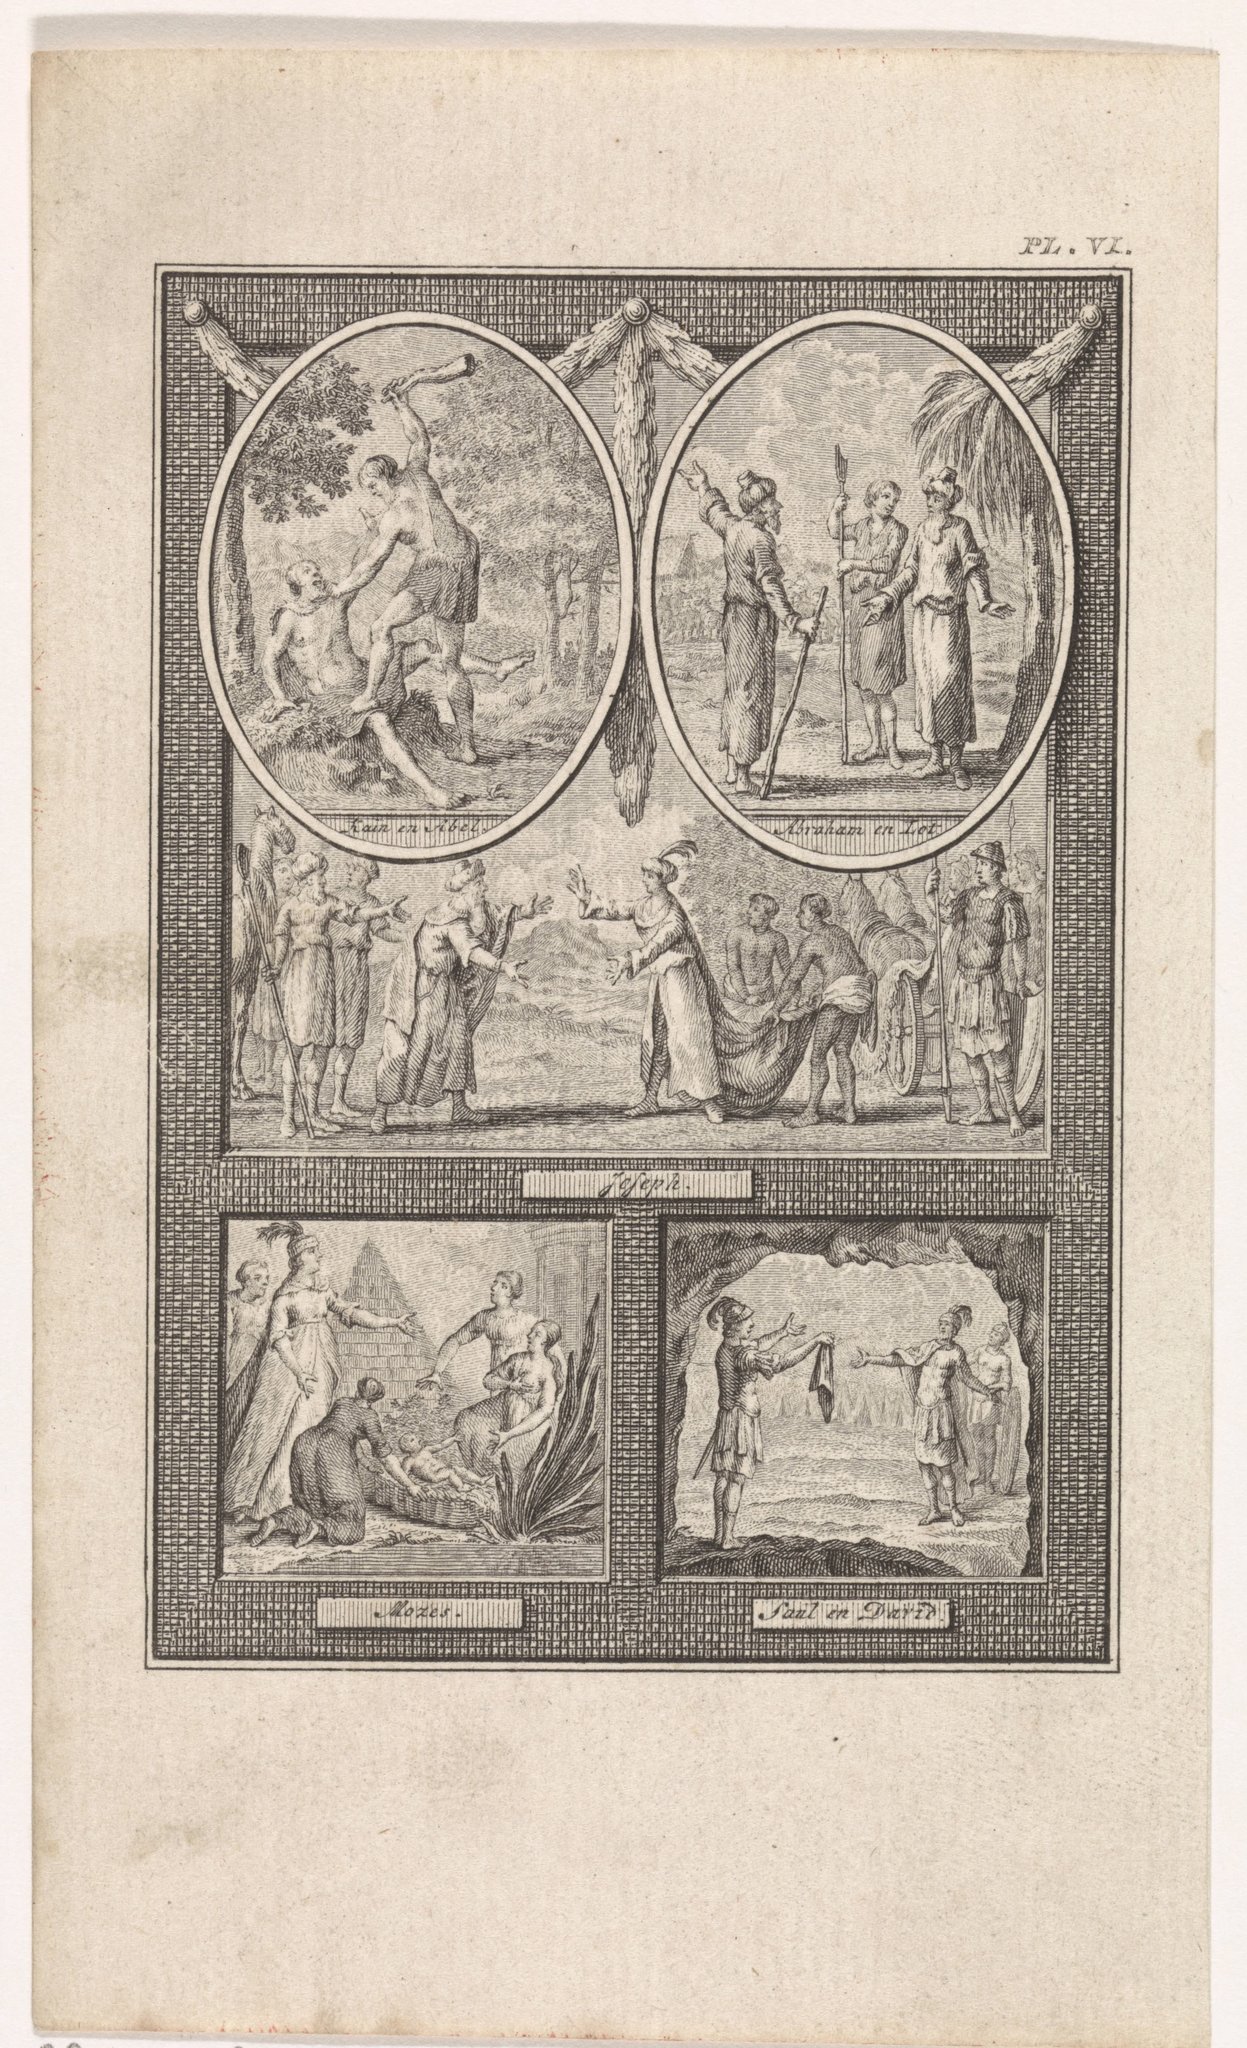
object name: book illustration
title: Vijf bijbelse taferelen op een blad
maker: theodoor koning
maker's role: print maker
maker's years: 1748-1829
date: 1794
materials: paper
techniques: etching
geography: amsterdam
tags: the killing of abel: cain slays him with a stone, a club or a jaw-bone, alternatively with a spade or another tool as weapon, saul and david in the same cave; saul relieving himself, abraham gives lot the choice of the surrounding country, joseph goes to goshen to meet his father, moses is either presented to pharaoh's daughter or surrounded by women fondling him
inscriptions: collector's mark: Lugt 2228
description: Linksboven een medaillon met Kaïn die Abel doodt (Genesis 4:8). Rechtboven een medaillon met Abraham en Lot die het land verdelen (Genesis 13:1-12). In het midden een afbeelding van Josef, koning van Egypte, met zijn gevolg (Genesis 46:29). Linksonder wordt Mozes, liggend in het mandje, gevonden en aan de dochter van de farao geschonken (Exodus 2). Rechtsonder toont David een stuk van zijn mantel aan Saul (1 Samuel 24:12). Deze prent is een illustratie uit 'Uitgezogte bĳbelsche verhaalen, tot een leesboek voor de jeugd'.